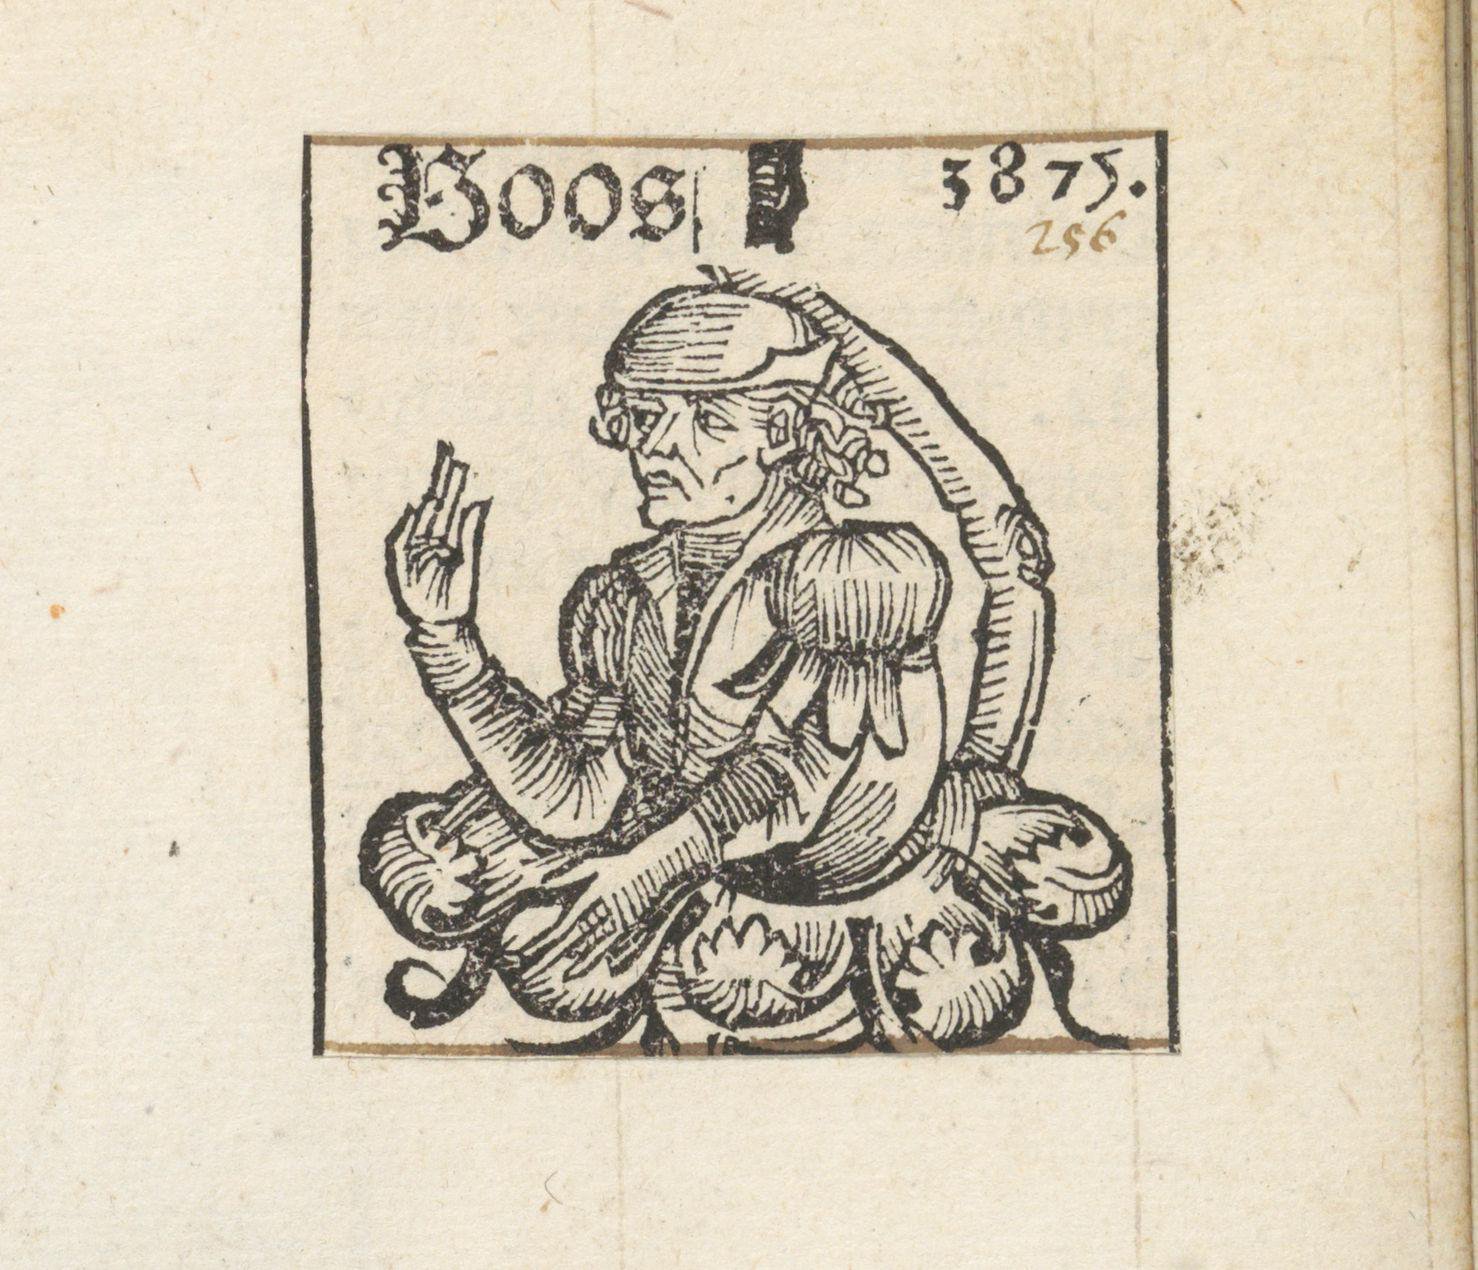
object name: print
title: Boaz (III)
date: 1493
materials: paper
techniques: letterpress printing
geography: nuremberg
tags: persons from the old testament (not in biblical context, nor occurring in legendary/historical extensions included in division 71)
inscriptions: inscription: ‘256’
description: Een bloemkelk met een man met hoed, naar links gericht. Hij steekt zijn linkerhand omhoog. De tekst identificeert hem als Boaz uit het jaar 3875. De voorstelling is onderdeel van de stamboom van Christus in de Liber Chronicarum. De prent maakt deel uit van een album.